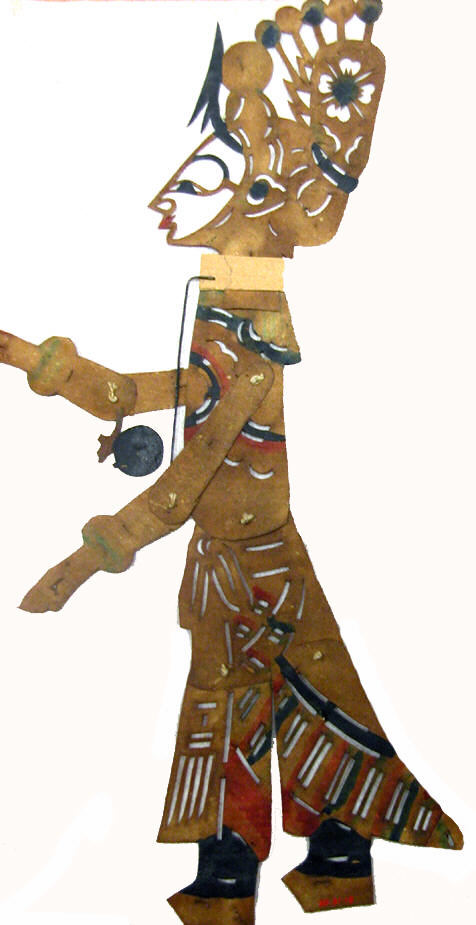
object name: shadow player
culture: chinese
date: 1801-1900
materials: cord, skin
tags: human figures